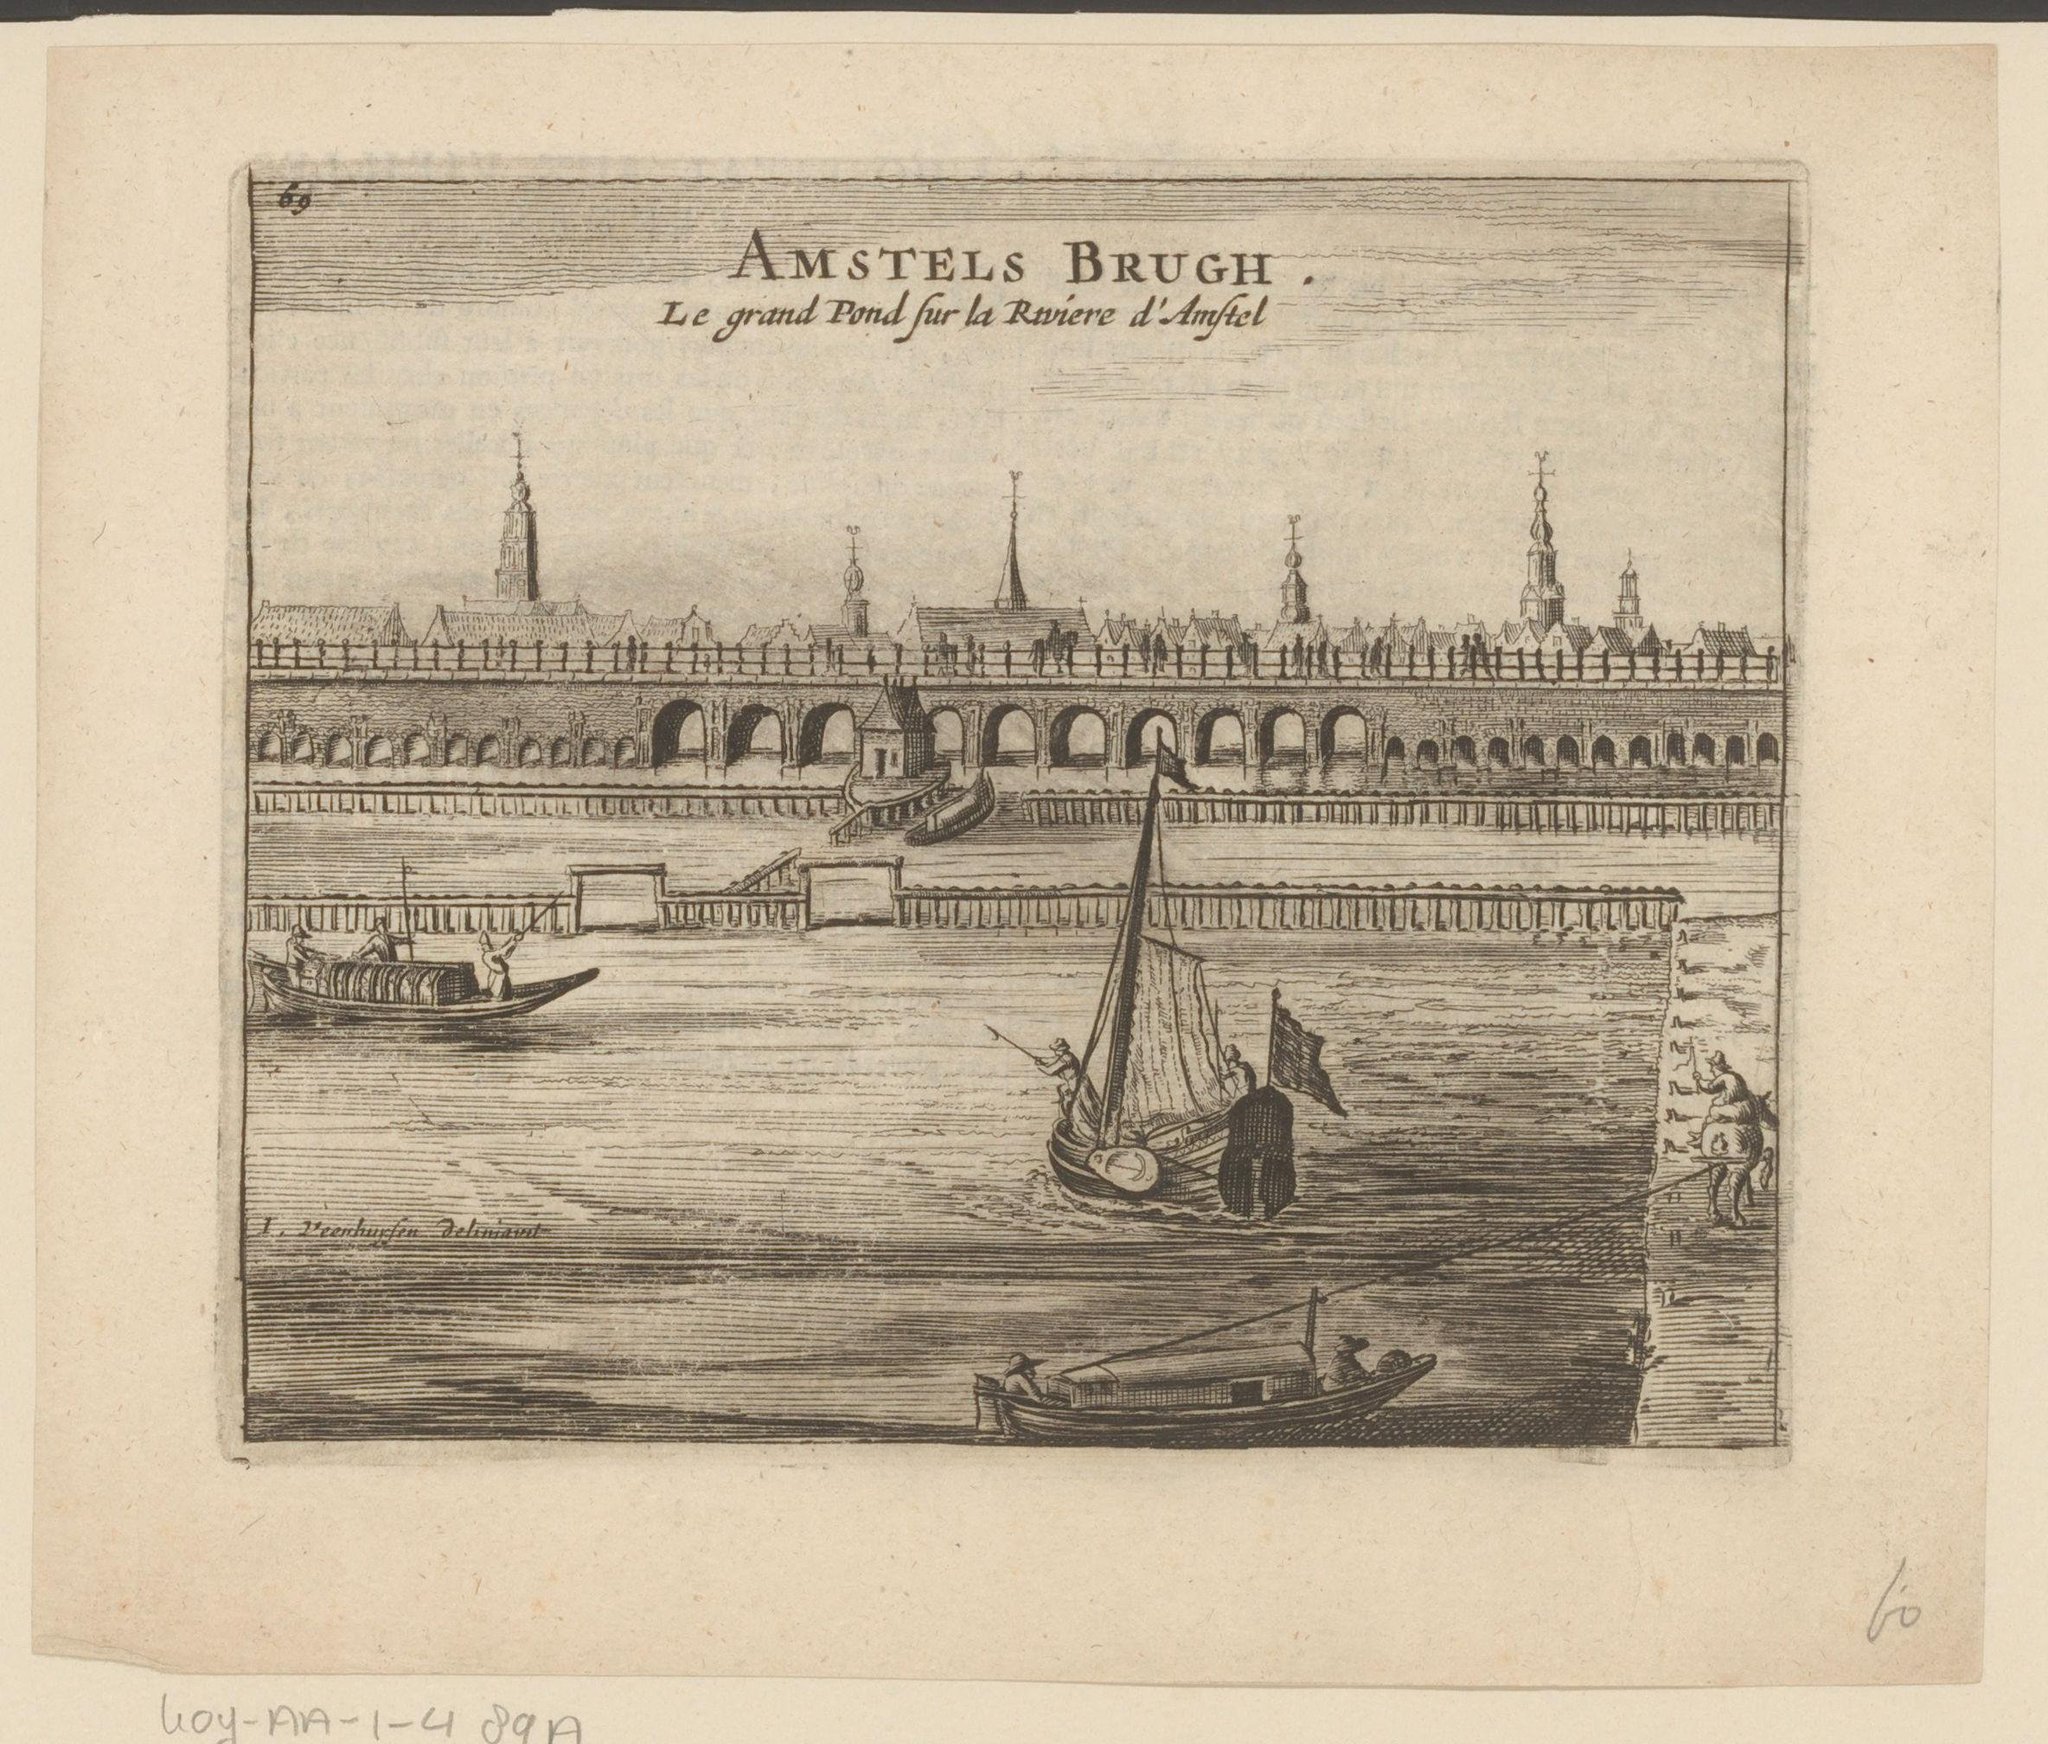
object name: book illustration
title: Amstels Brugh Le grand Pond sur la Riviere d'Amstel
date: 1713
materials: paper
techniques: engraving, etching, letterpress printing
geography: amsterdam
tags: sailing-ship, sailing-boat, city-view in general; 'veduta', river, bridge in city across river, canal, etc.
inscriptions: collector's mark: ‘4C’ Lugt 1641b, inscription: ‘Legaat Joh. M. Coffeng. 1966’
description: Prent uit: Beknopte beschryving van alle de voornaamste gebouwen der wydvermaarde koopstad Amsterdam, cierlyk in't koper afgebeeld (...). Amsterdam: Dirk Schouten, 1713. Eerst bekende staat gebruikt in: Fockens, Melchior. Beschrijving Der wijdt-vermaarde Koop-stadt Amstelredam, Van haar eerste beginselen, zedert den Jare 1203. oude Voorrechten, verscheyde Vergrootingenoude Voor-rechten, en verscheyde Vergrootingen (…). 3e druk. Amsterdam: Marcus Willemsz. Doornick, 1664. En in: Zesen, Philipp von. Beschrybung der Weidtberuhmde Kauf-Stadt Amstelredam / Beschreibung der Stadt Amsterdam darinnen von derselben ersten ursprunge bis auf gegenwartigen zustand (…). Amsterdam: Marcus Willemsz. Doornick, 1664. Tweede bekende staat (met toevoeging Franse titel) ook gebruikt in: Domselaer, Tobias en Isaac Commelin. Beschryvinge van Amsterdam : haar eerste oorspronk uyt den huyze der heeren van Aemstel en Aemstellant (…). 6 delen. Amsterdam: Marcus Willemsz van Doornick, 1665.